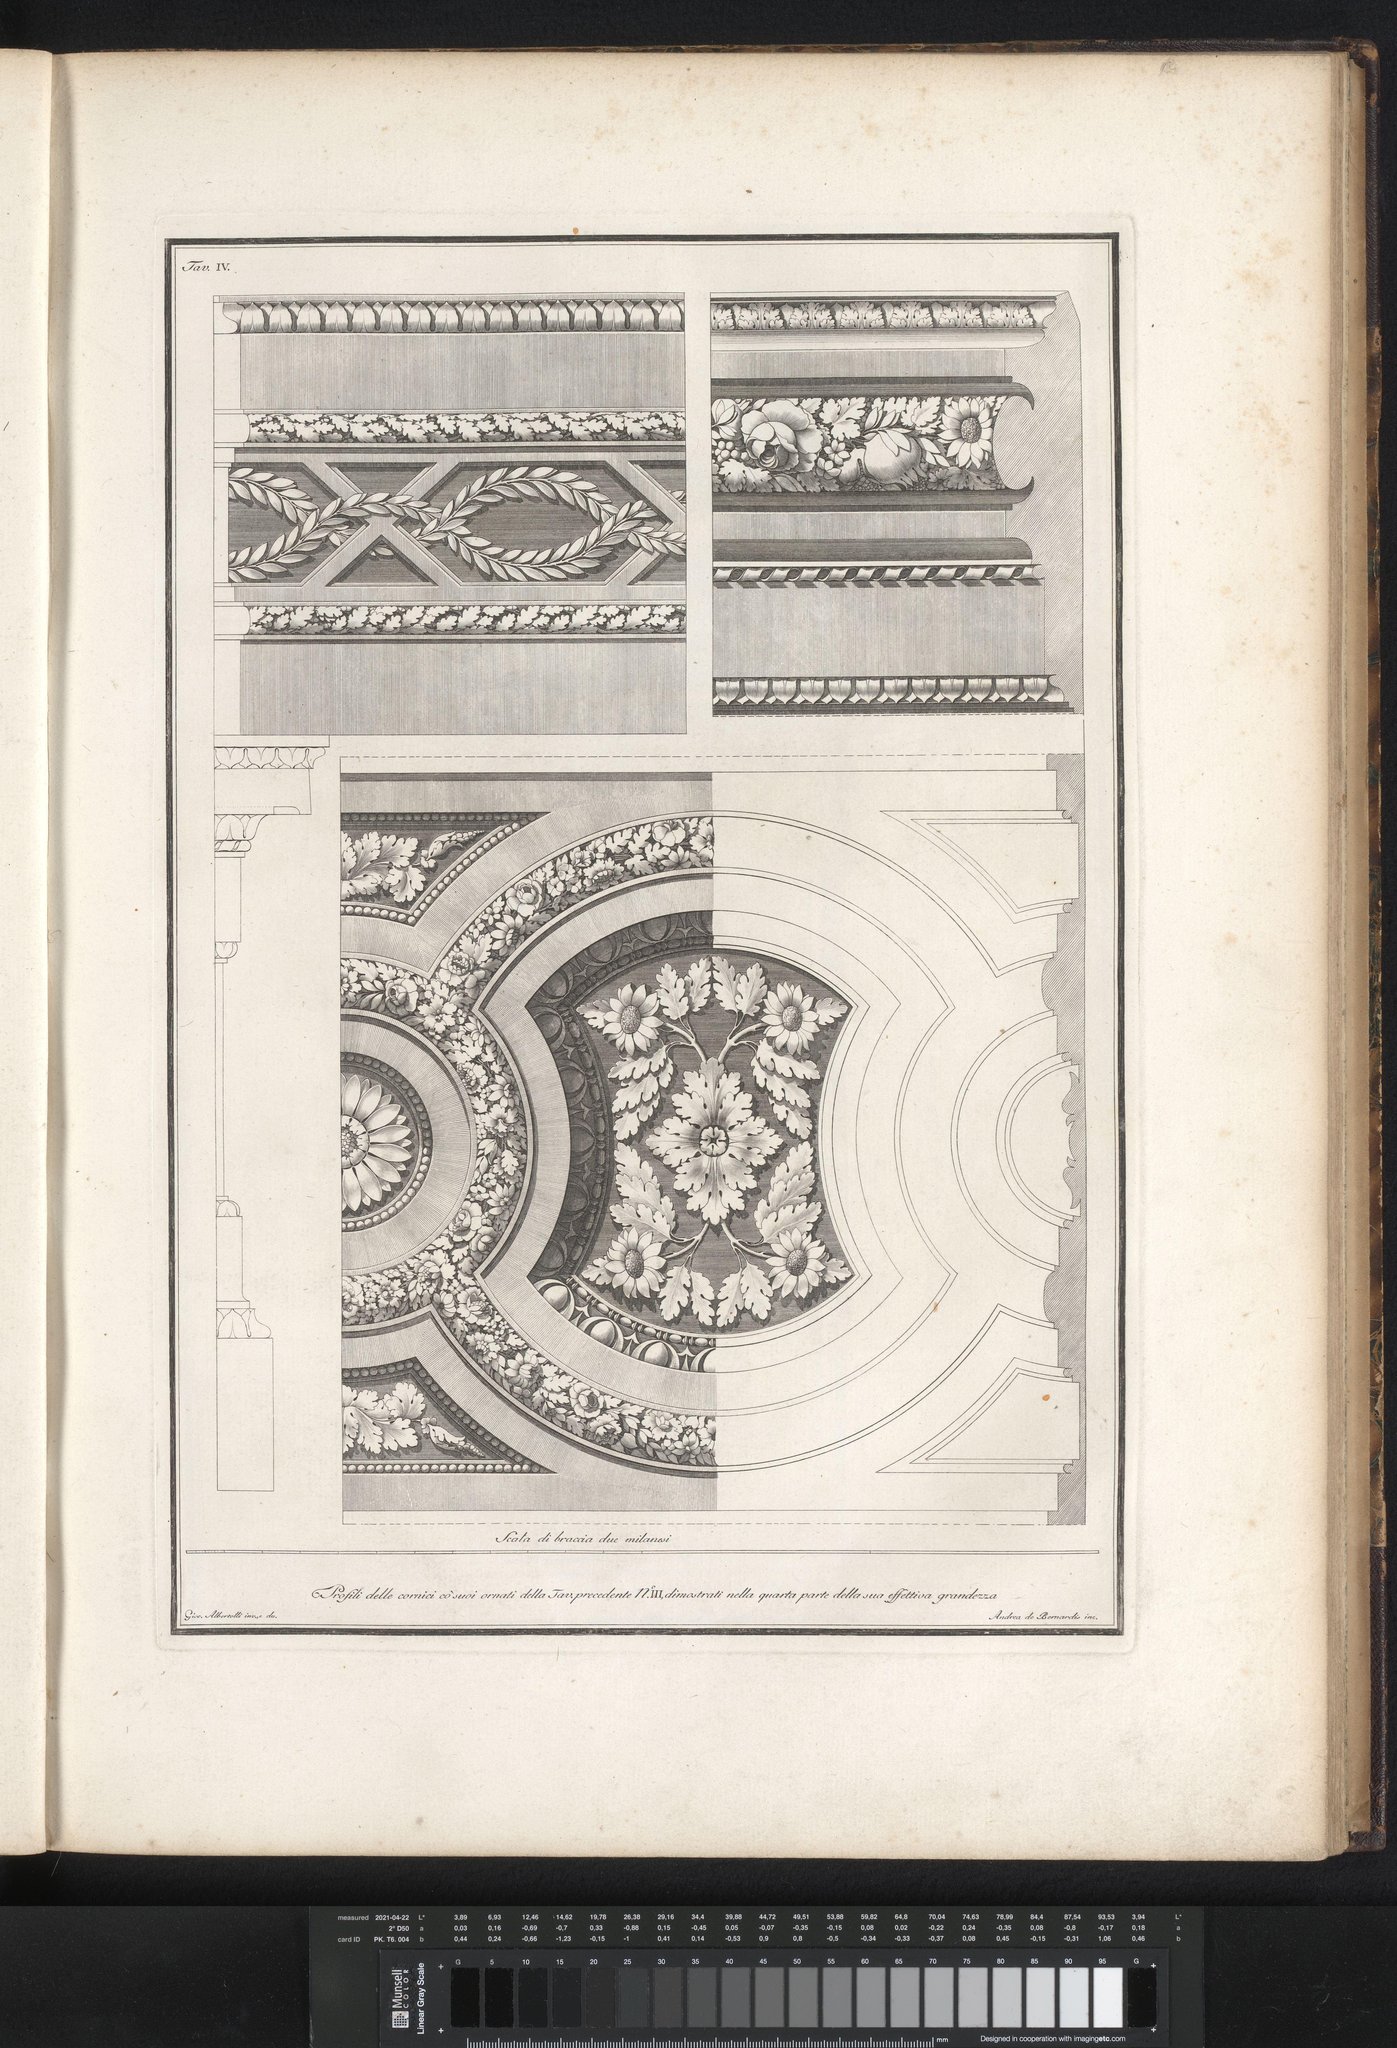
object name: ornament print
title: Drie sierlijsten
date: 1787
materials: paper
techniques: engraving, etching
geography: milan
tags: ornaments ~ art, mouldings ~ architecture, architectural detail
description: Drie sierlijsten. Decoratie voor de Villa Reale in Monza. Tavola IV. Onderdeel van het album met twee series ornamentprenten naar Giocondo Albertolli.